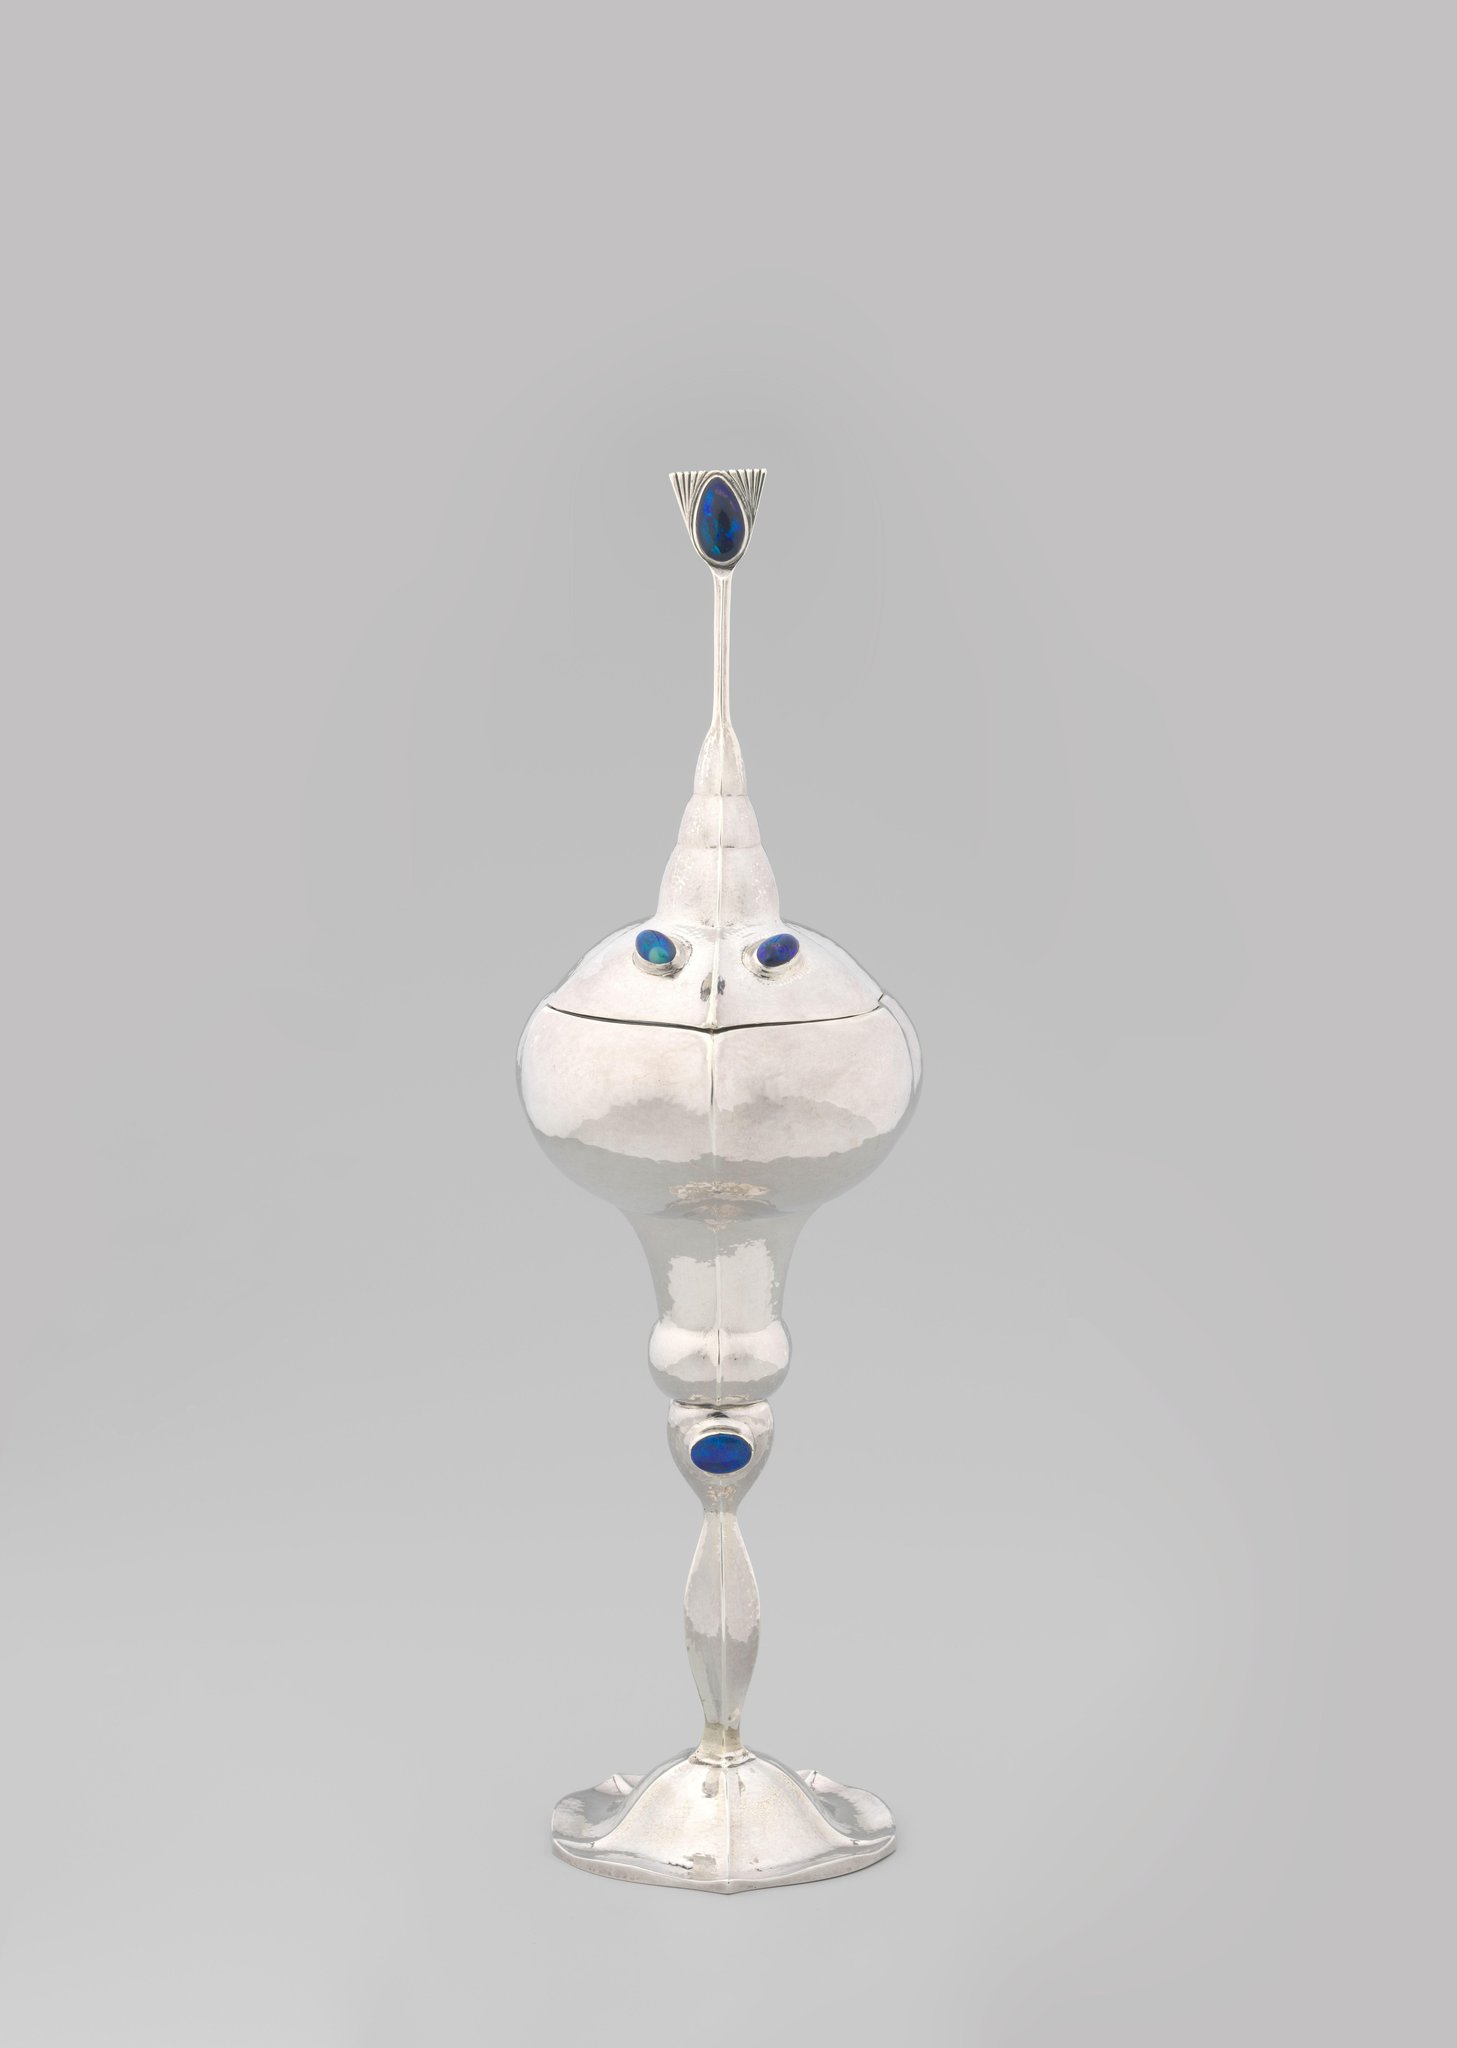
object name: ciborium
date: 1912-1916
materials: opal, silver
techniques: repoussé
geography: hagen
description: This ciborium – a vessel used in Christian worship for the consecrated bread – depicts the interaction between man and the universe with pentagons, triangles andspirals. Lauweriks was following the Theosophical tenet that every philosophy of life contains a fragment of the divine mystery. Lauweriks therefore chose opals, which reflect light in a thousand colours; as many as there are human interpretations of the divine.